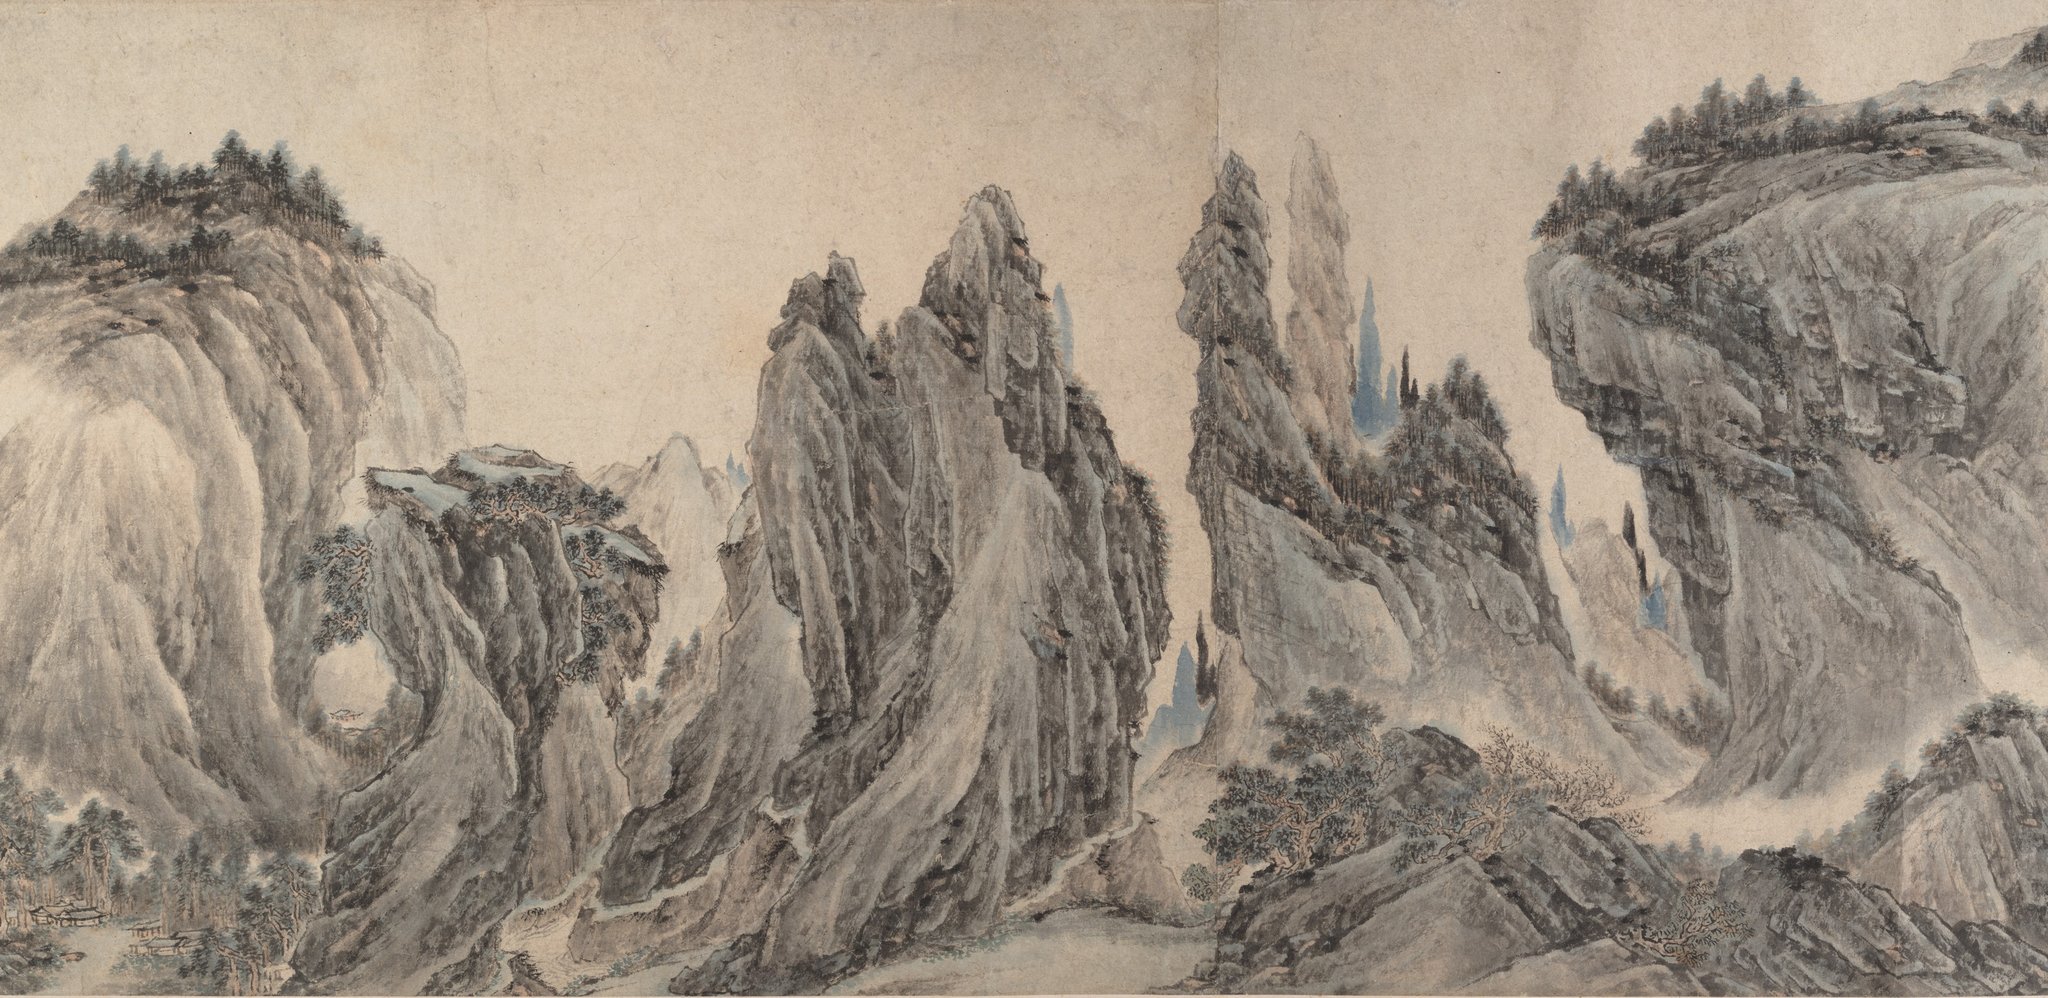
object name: handscroll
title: Landscape after Dong Yuan, Juran, Ma Yuan, and Xia Gui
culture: chinese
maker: li zai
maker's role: artist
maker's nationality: chinese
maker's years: 1600-1699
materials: ink, paper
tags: mountains,landscapes